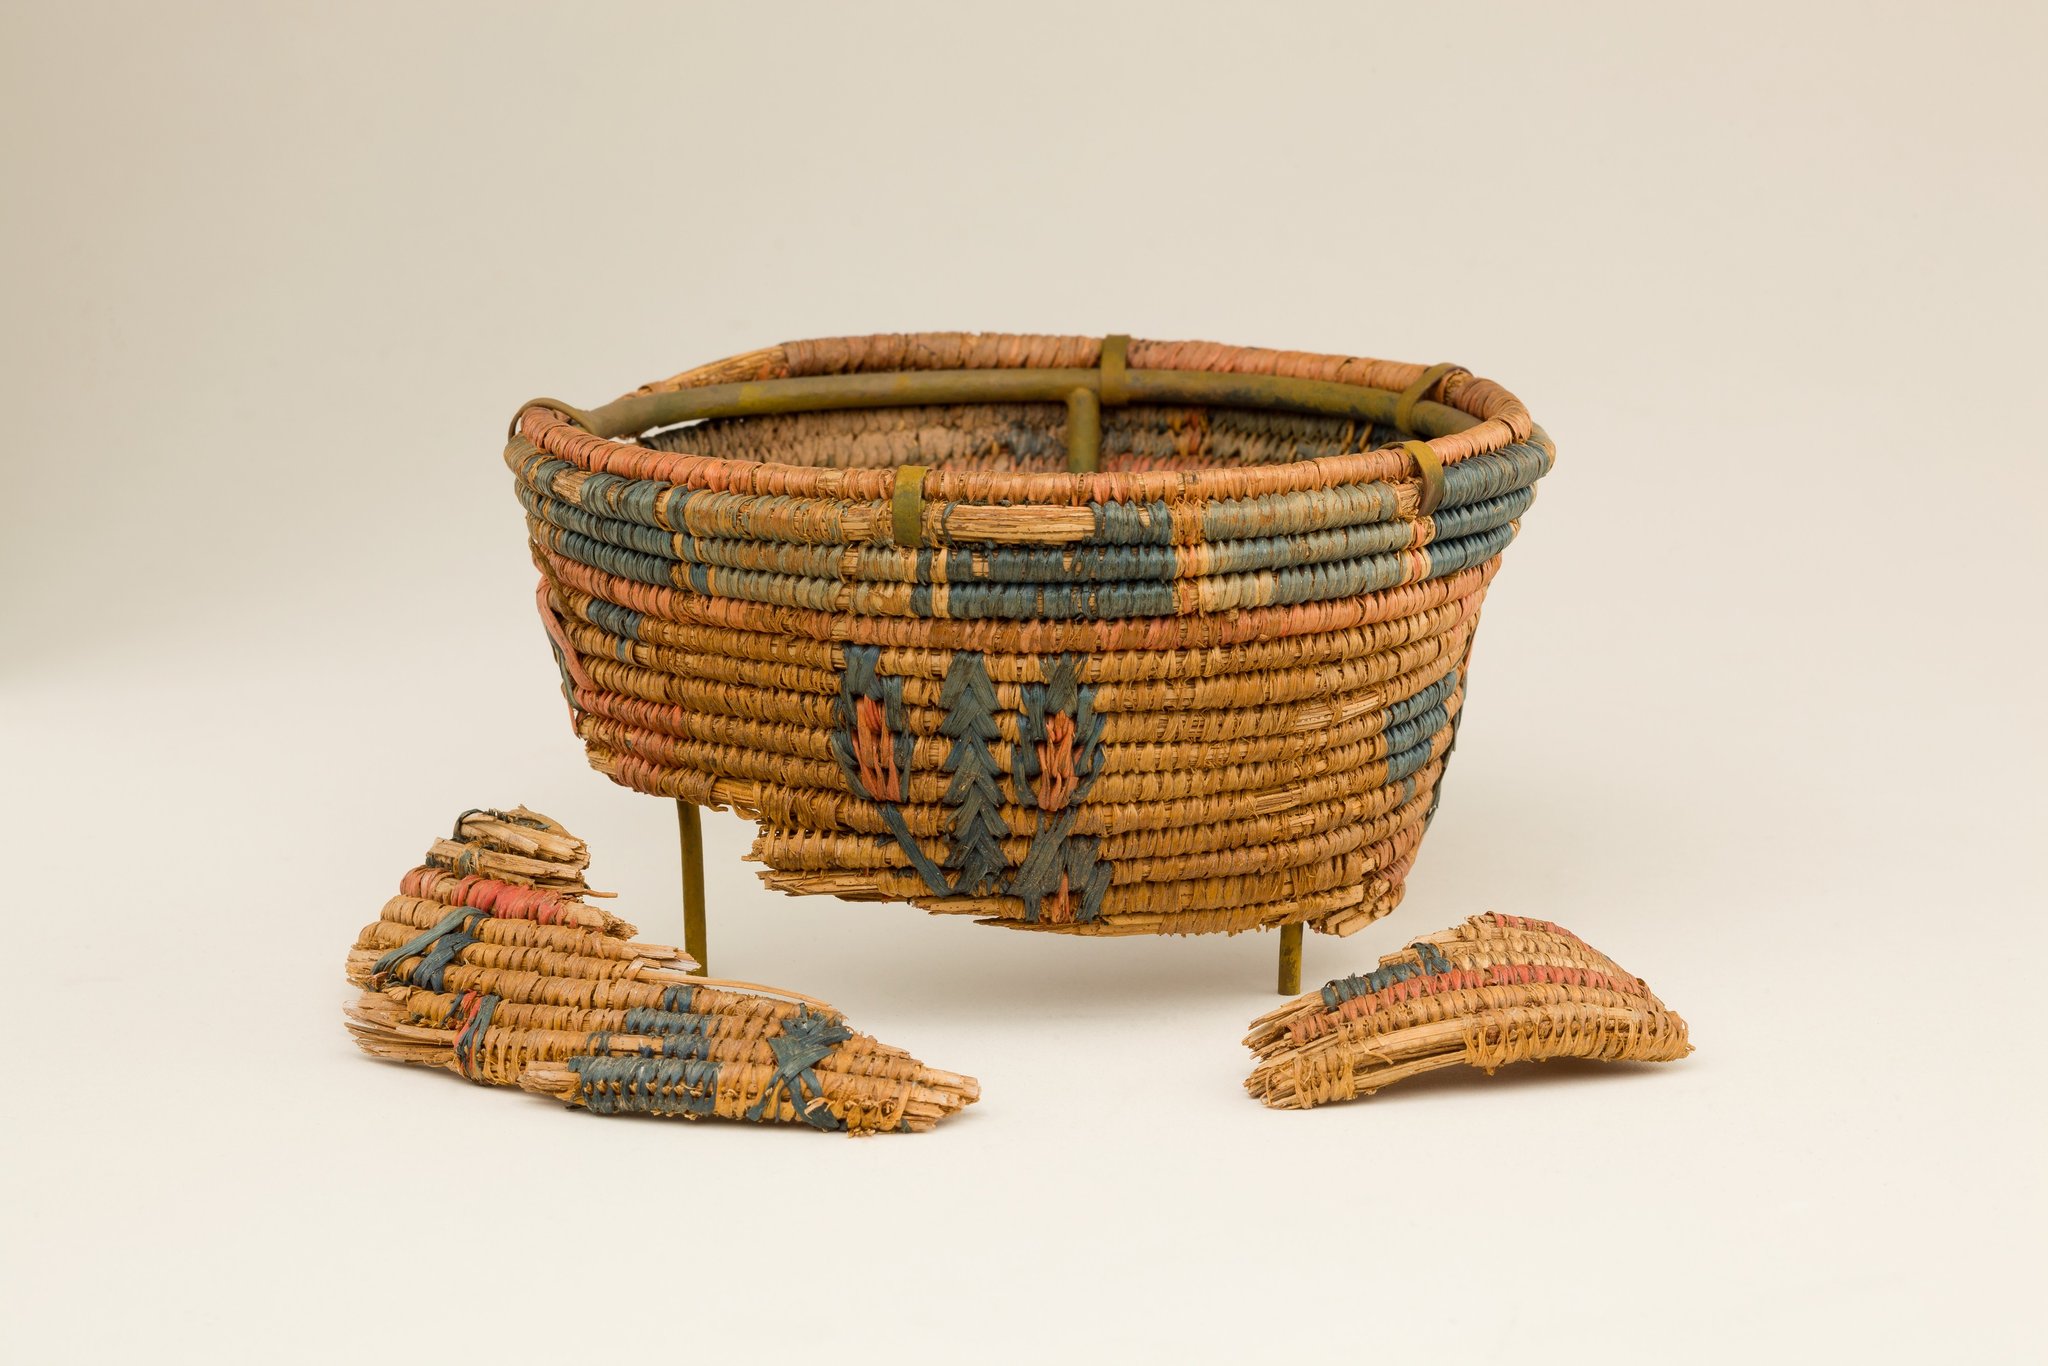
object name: basket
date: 1295-1070 BCE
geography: egypt